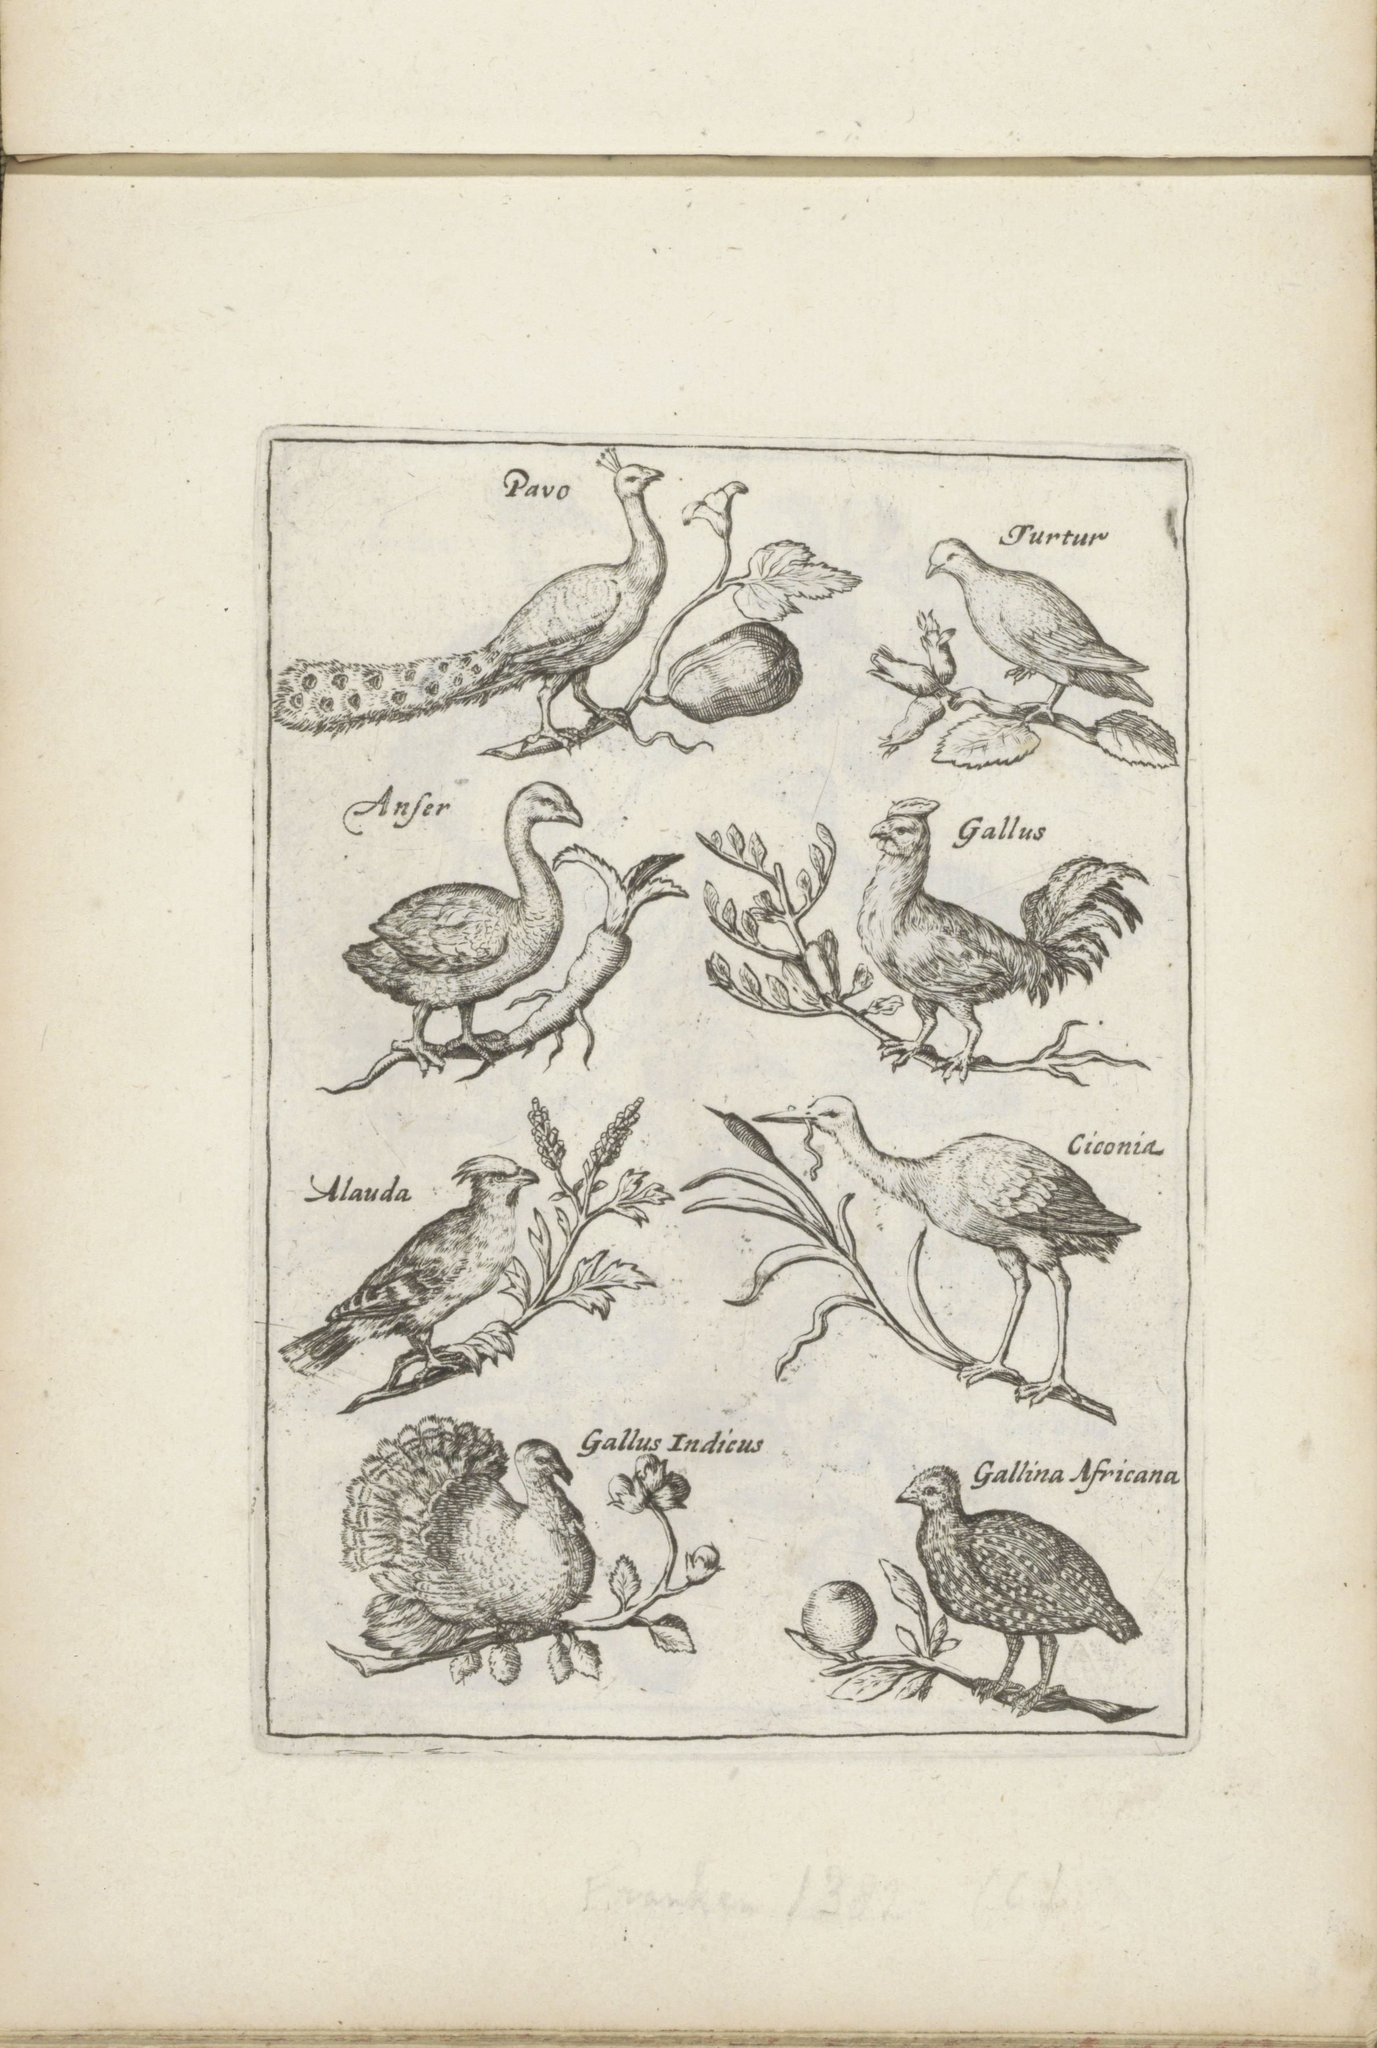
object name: album leaf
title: Pauw, duif en andere vogels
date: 1635-1660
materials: paper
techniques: engraving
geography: utrecht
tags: other birds: dove, water-birds: goose, shore-birds and wading-birds: stork, ornamental birds: peacock, fowl (cock, hen, chicken, etc.), song-birds: lark, walker and runner birds: turkey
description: Acht vogels op takken, ieder met de naam in het Latijn. Pauw, duif, gans, kamhoen, leeuwerik, ooievaar, kalkoen en parelhoen. Deze prent maakt deel uit van een album.